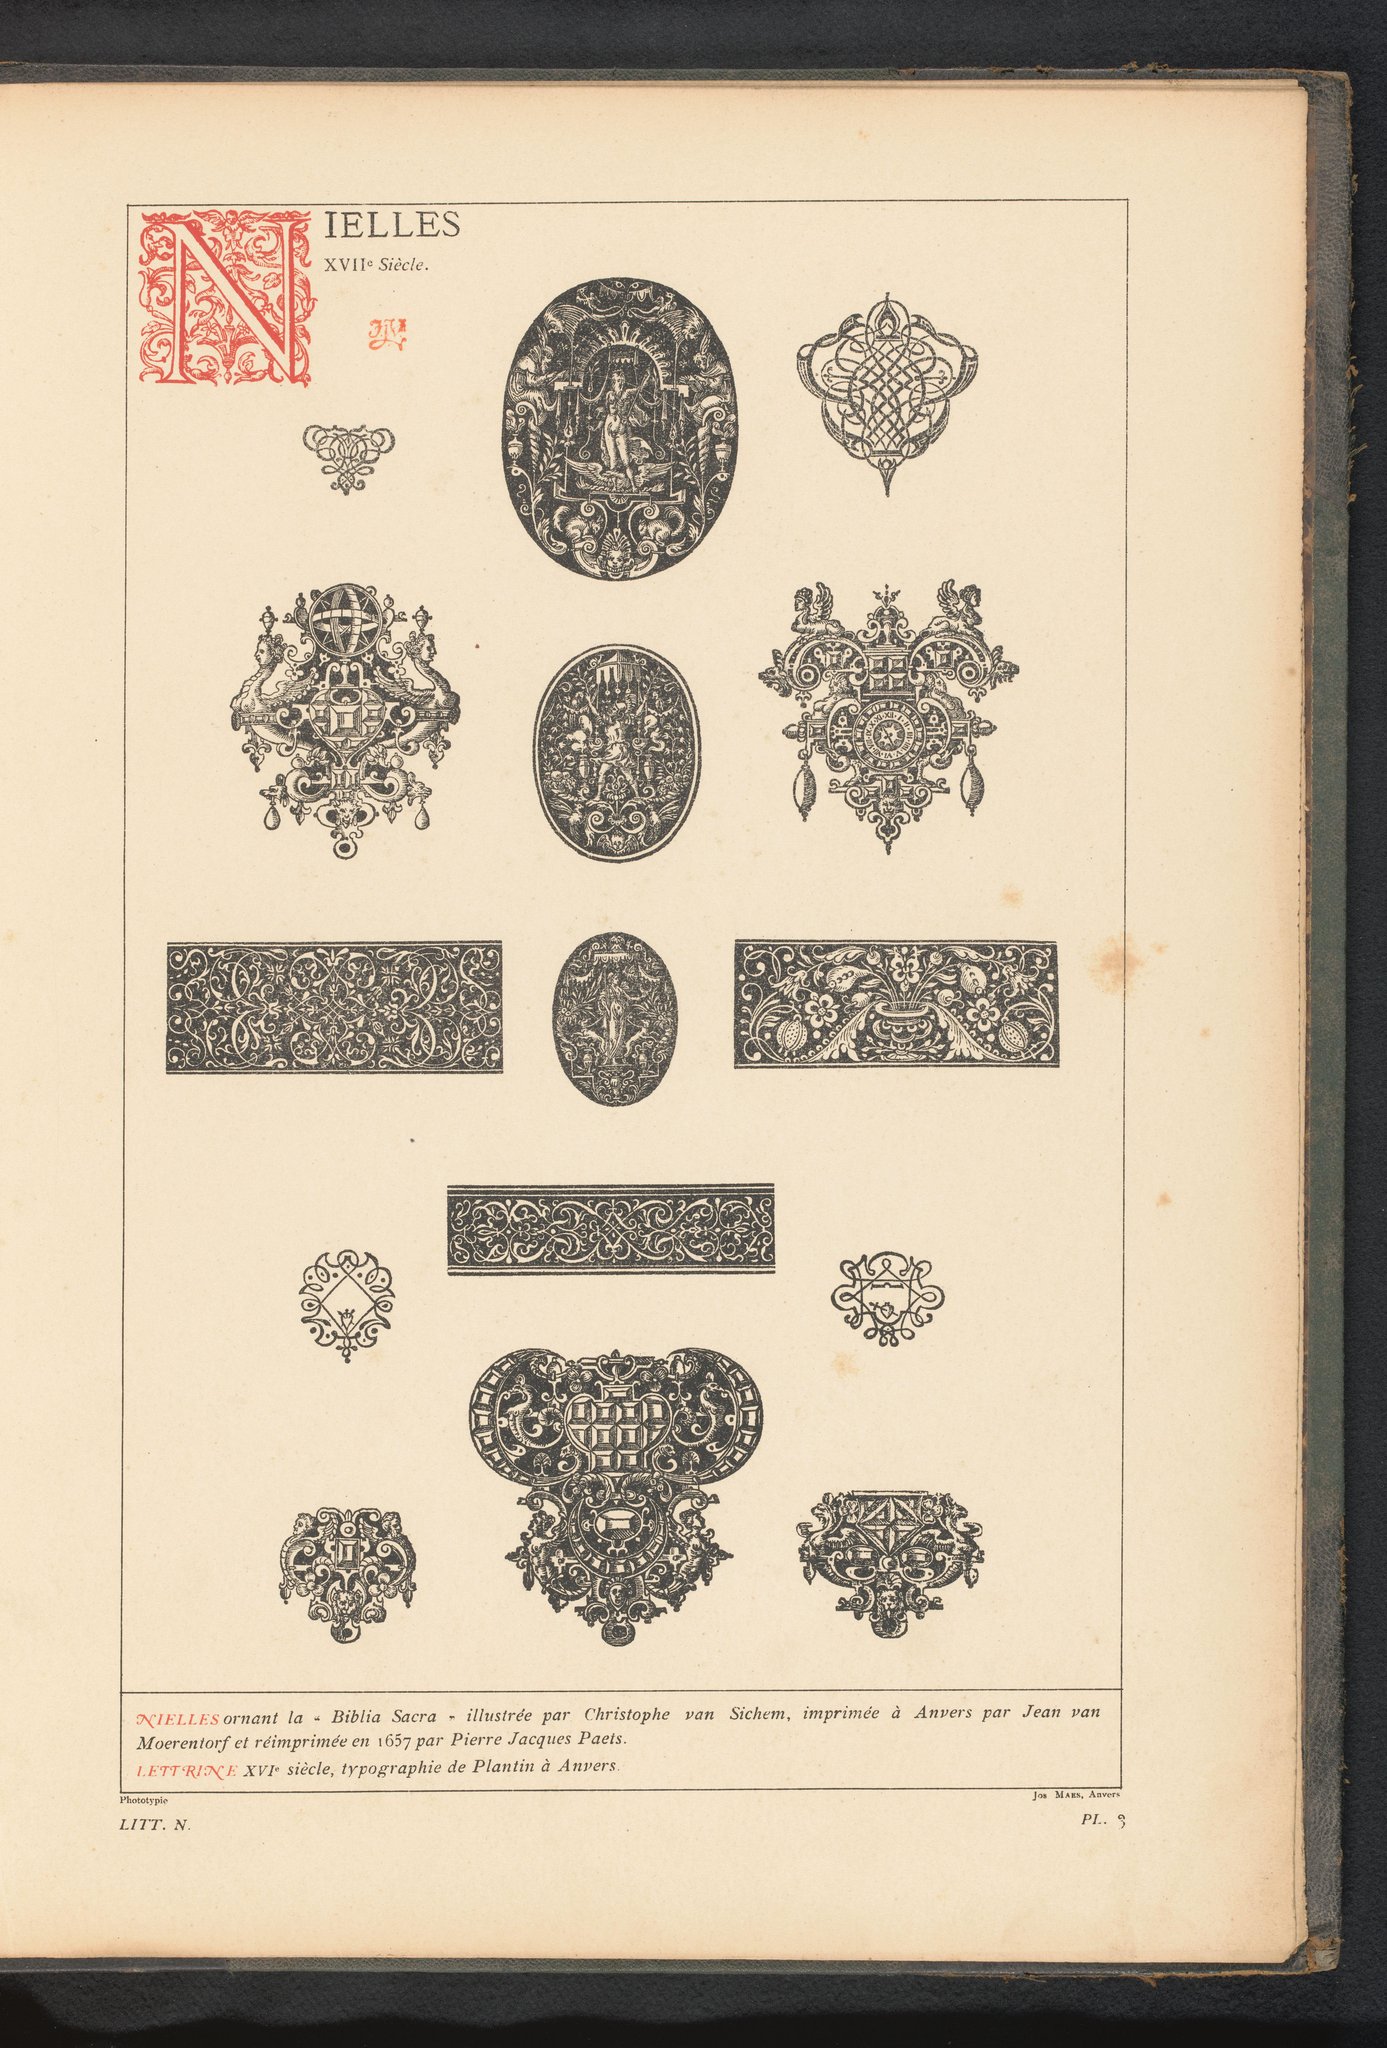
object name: page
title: Reproductie van vijftien prenten van decoraties voor een Biblia Sacra door Christoffel van Sichem II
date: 1875-1880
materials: paper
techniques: photolithography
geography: antwerp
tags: ornamental decoration ~ printed matter, book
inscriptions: inscription: ‘LITT. N. PL. 3’, inscription: ‘NIELLES ornant la (...)’, monogram: ‘JJvY’